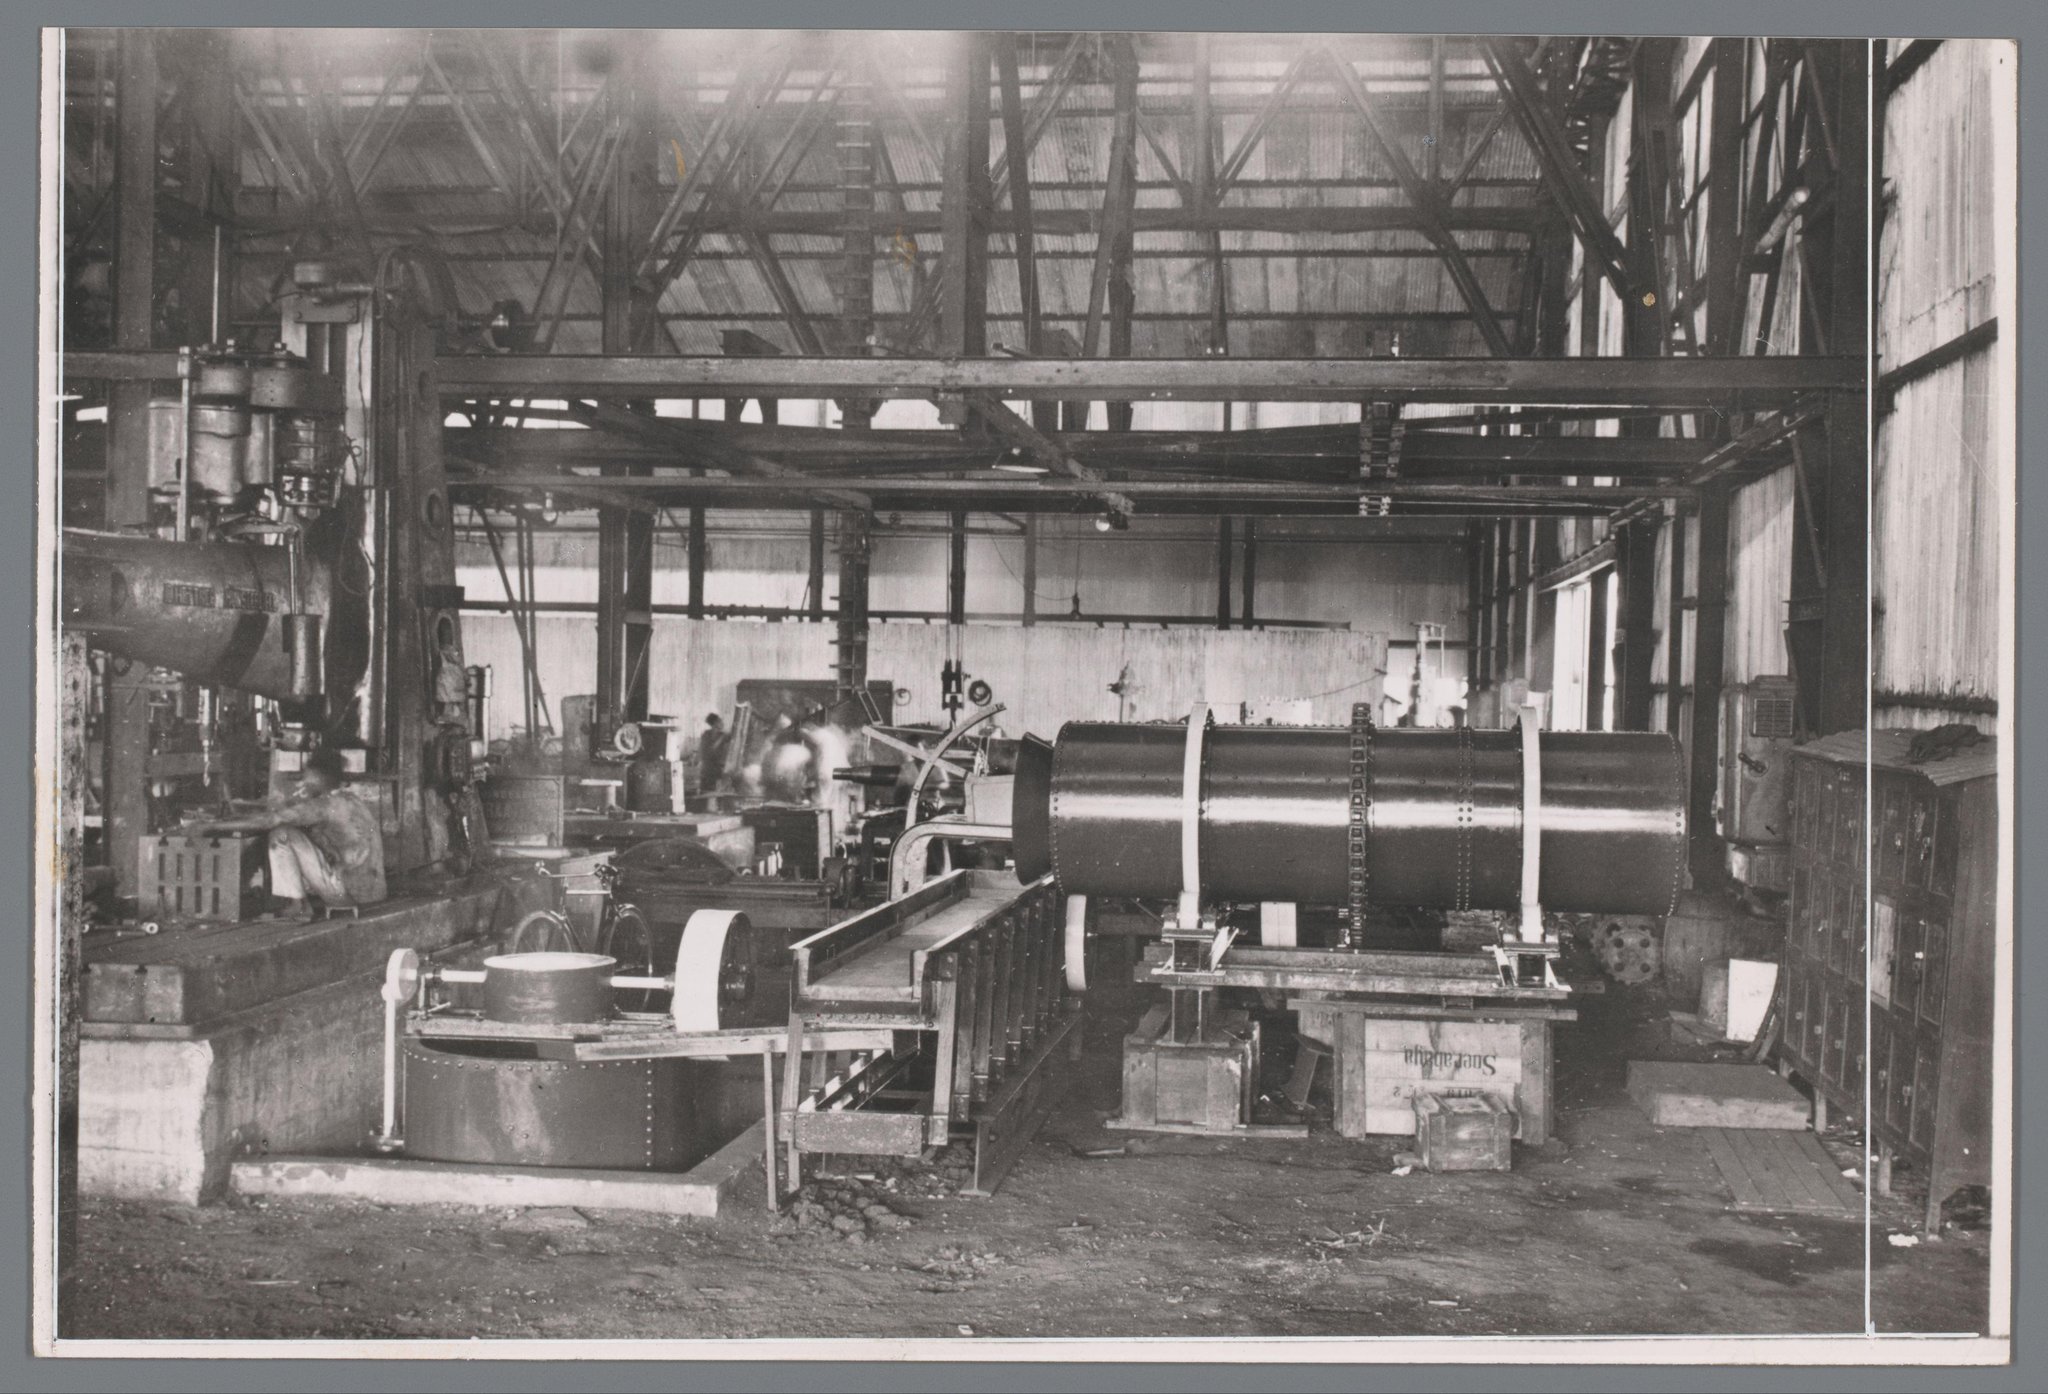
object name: photograph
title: Lime-milk installatie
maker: Anonymous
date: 1920-1940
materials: photographic support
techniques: gelatin silver print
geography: surabaya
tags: colonial system, factory-interior, machine shop, machines; parts of machines; tools and appliances, java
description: Lime-milk of kalkmelk installatie voor de productie van calciumhydroxide, in bedrijf. Onderdeel van de multomap met foto's van machines van de N.V. Machinefabriek Braat te Soerabaja, Soekaboemi en Jogyakarta, uit de periode 1908-1942.